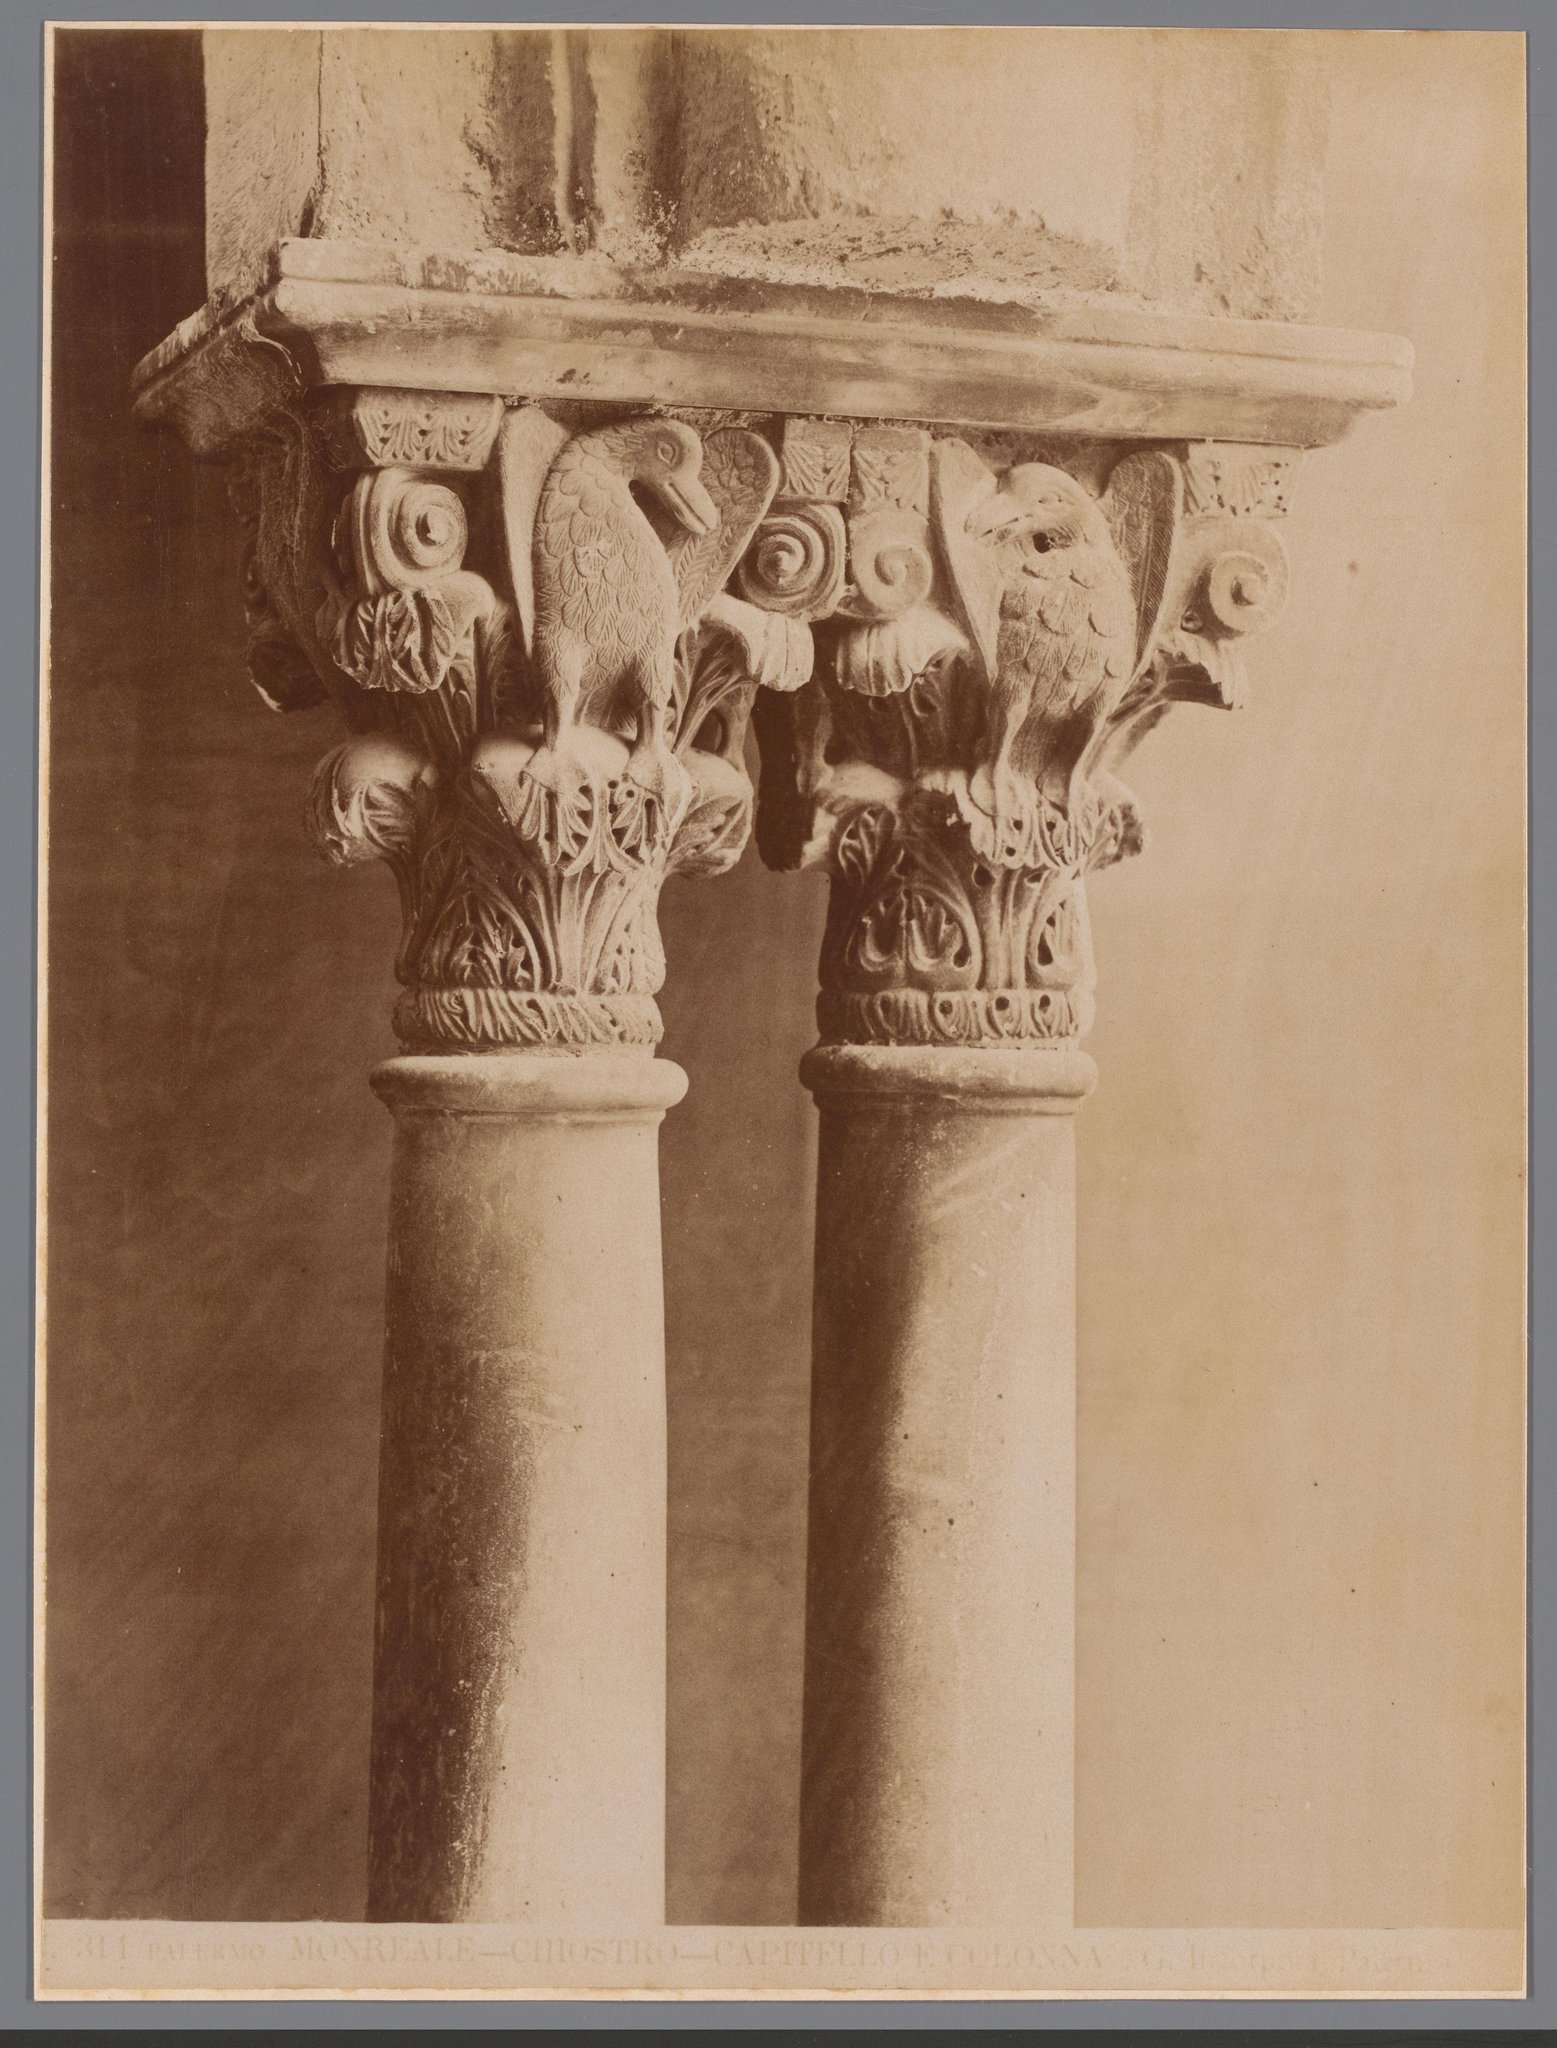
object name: photograph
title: Monreale, Chiostro, capitello e colonna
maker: giuseppe incorpora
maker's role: fotograaf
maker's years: 1834-1914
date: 1856-1914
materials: cardboard, paper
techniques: albumen print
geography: monreale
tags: abbey, monastery, convent ~ roman catholic church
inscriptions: number: ‘N. 311’